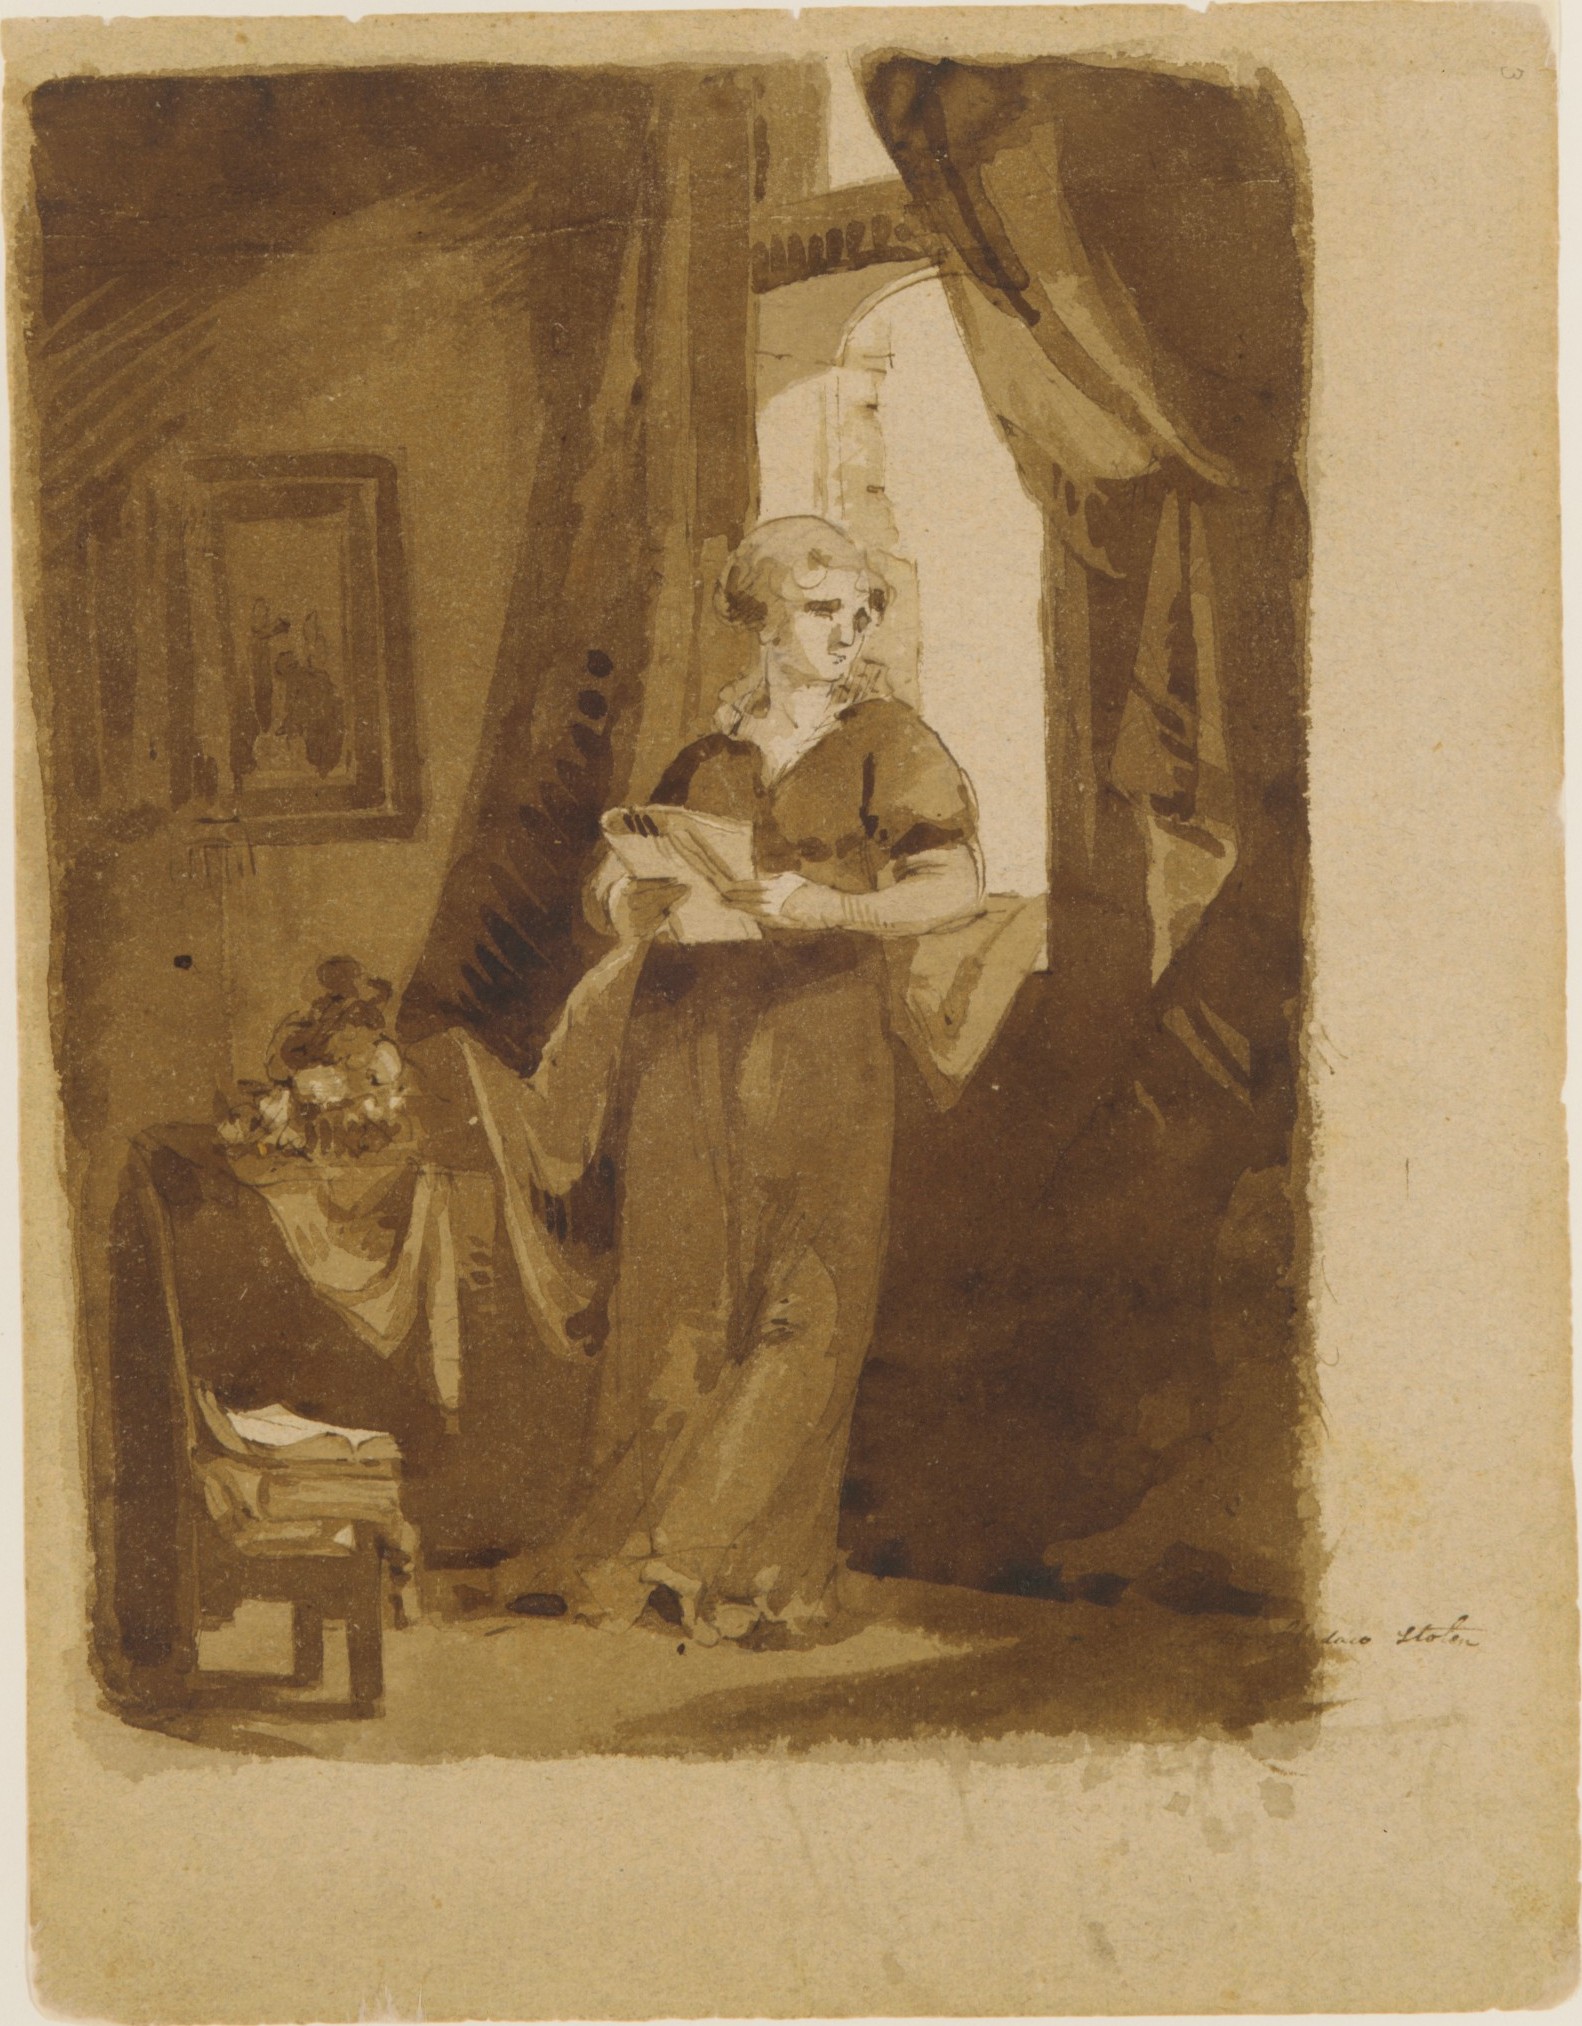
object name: drawing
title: Woman at a Window (from Sketchbook)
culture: american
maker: thomas sully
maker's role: artist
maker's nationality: american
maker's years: 1783-1872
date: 1810-1820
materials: ink, paper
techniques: pen, wash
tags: women